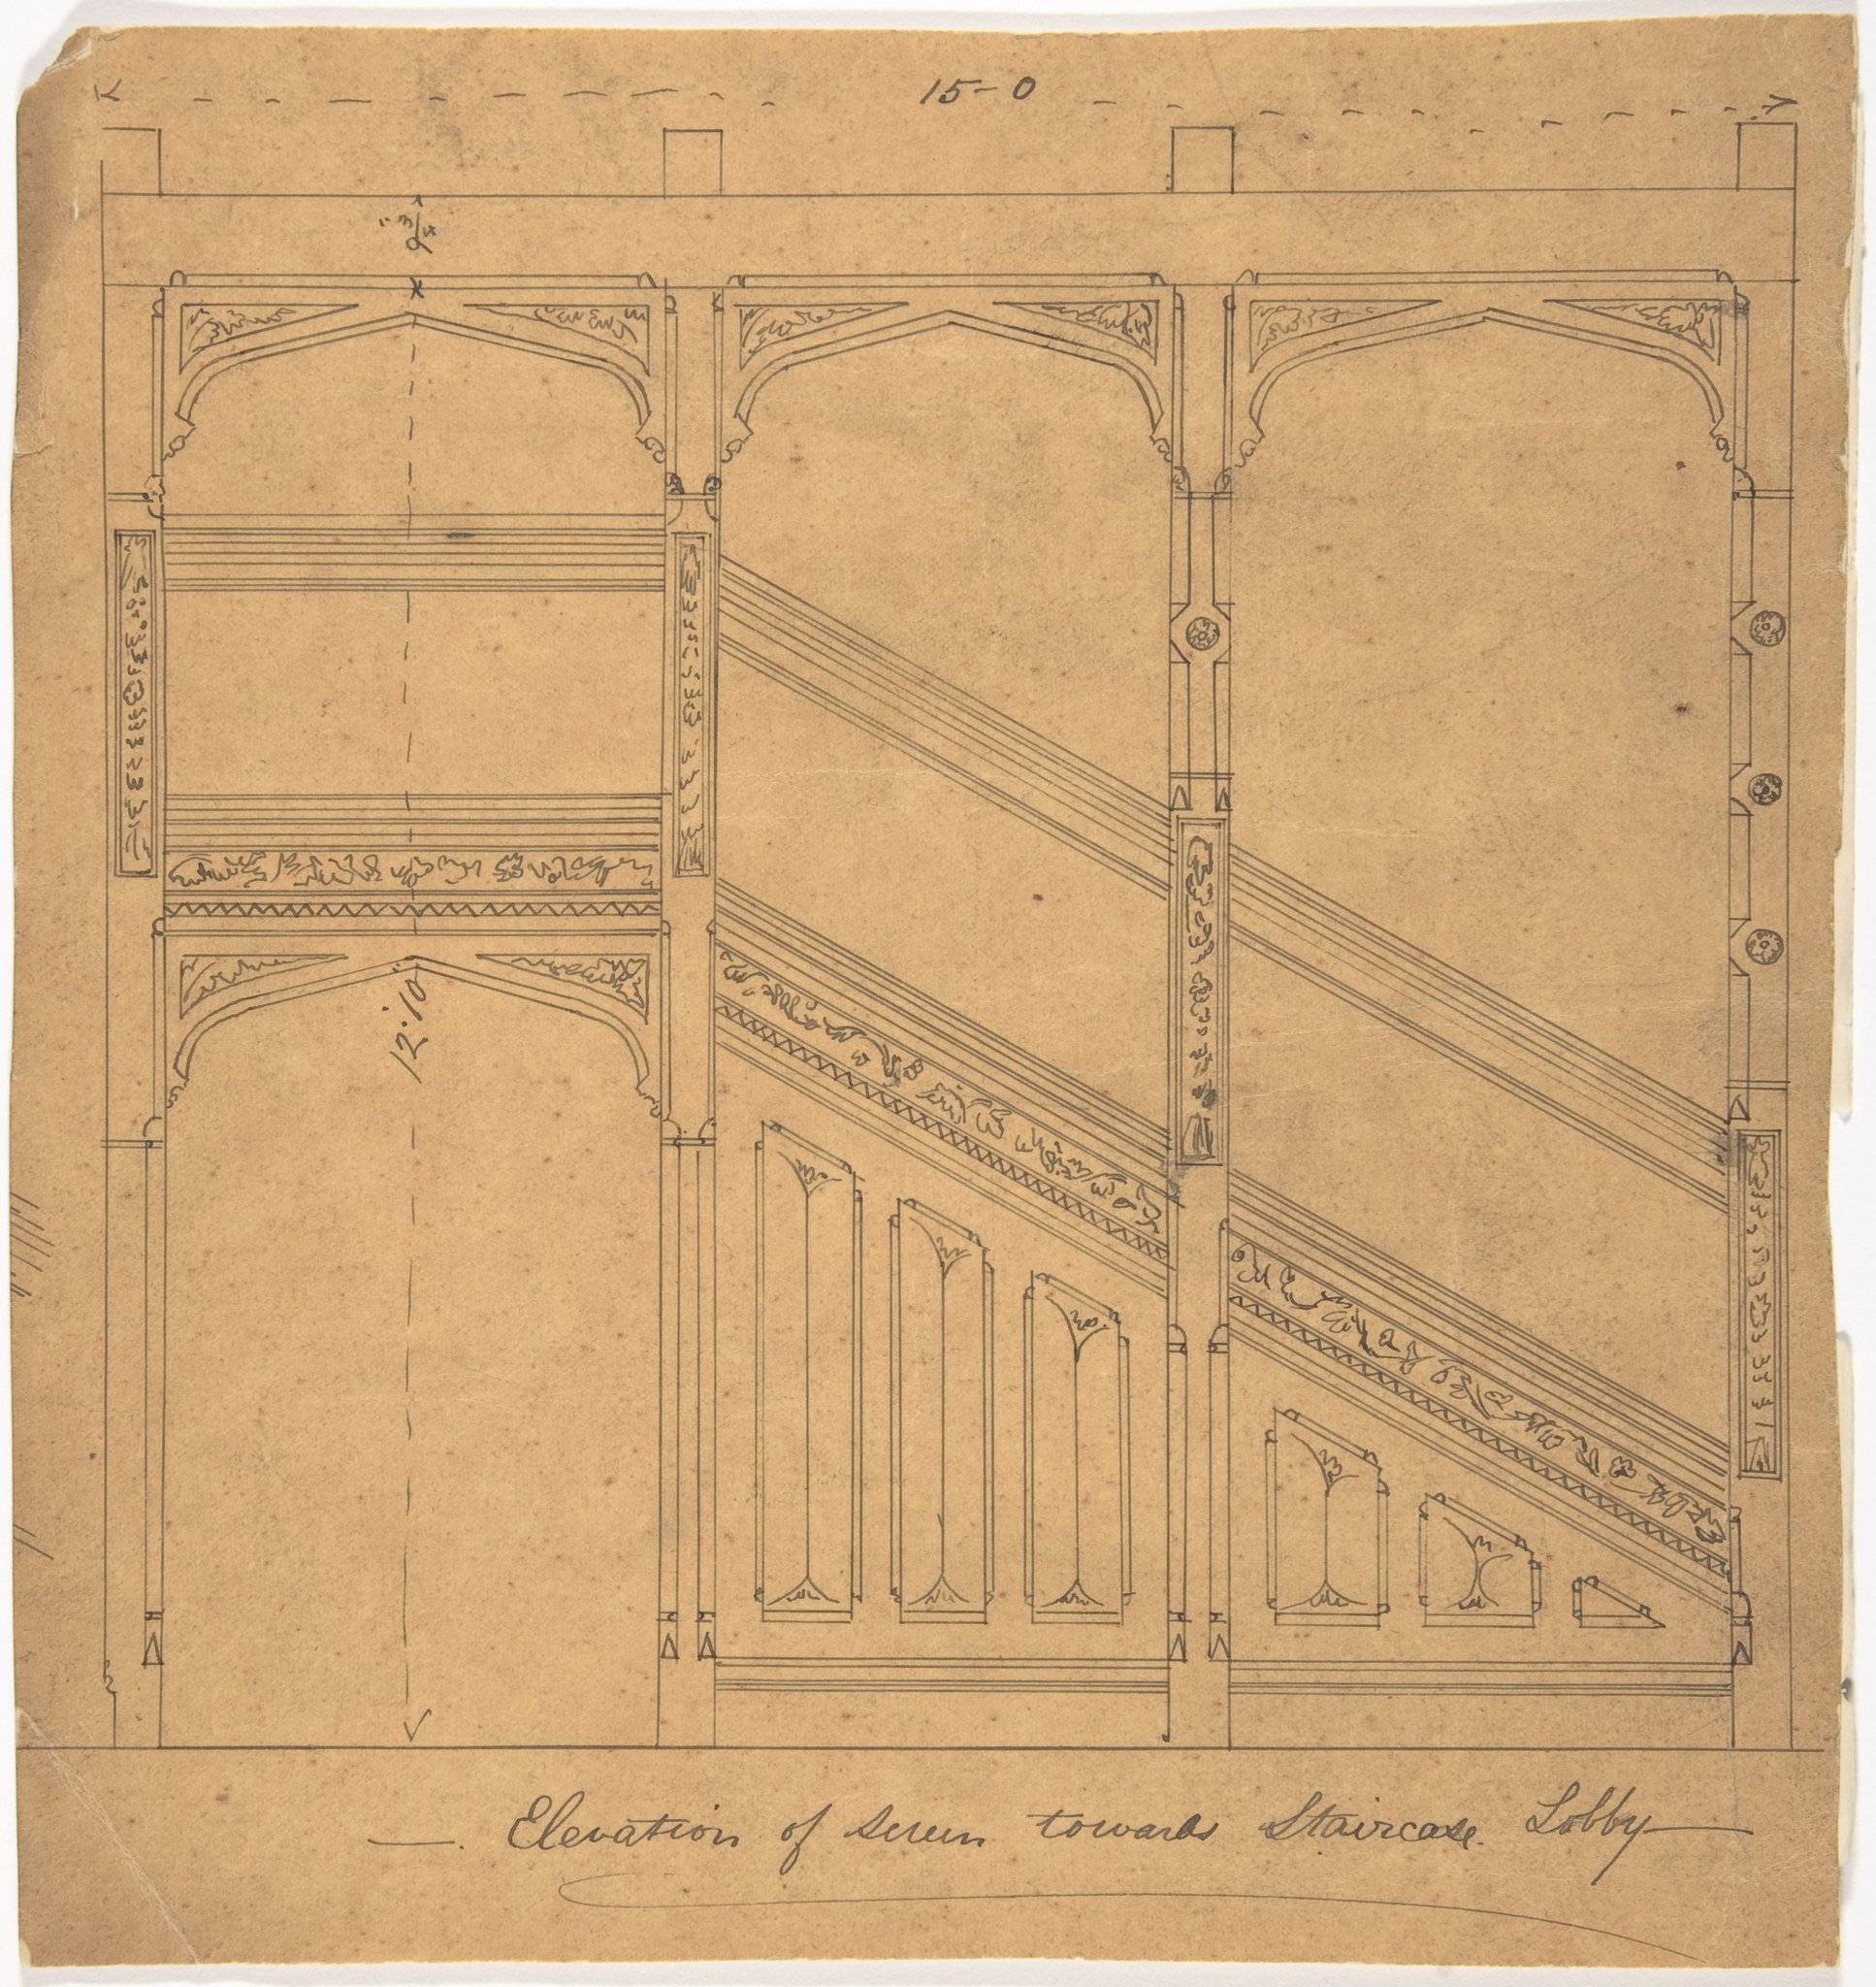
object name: drawing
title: Staircase Lobby Design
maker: anonymous, british, 19th century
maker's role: artist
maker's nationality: british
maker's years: 1800-1900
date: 1801-1900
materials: ink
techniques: pen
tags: architecture,stairs